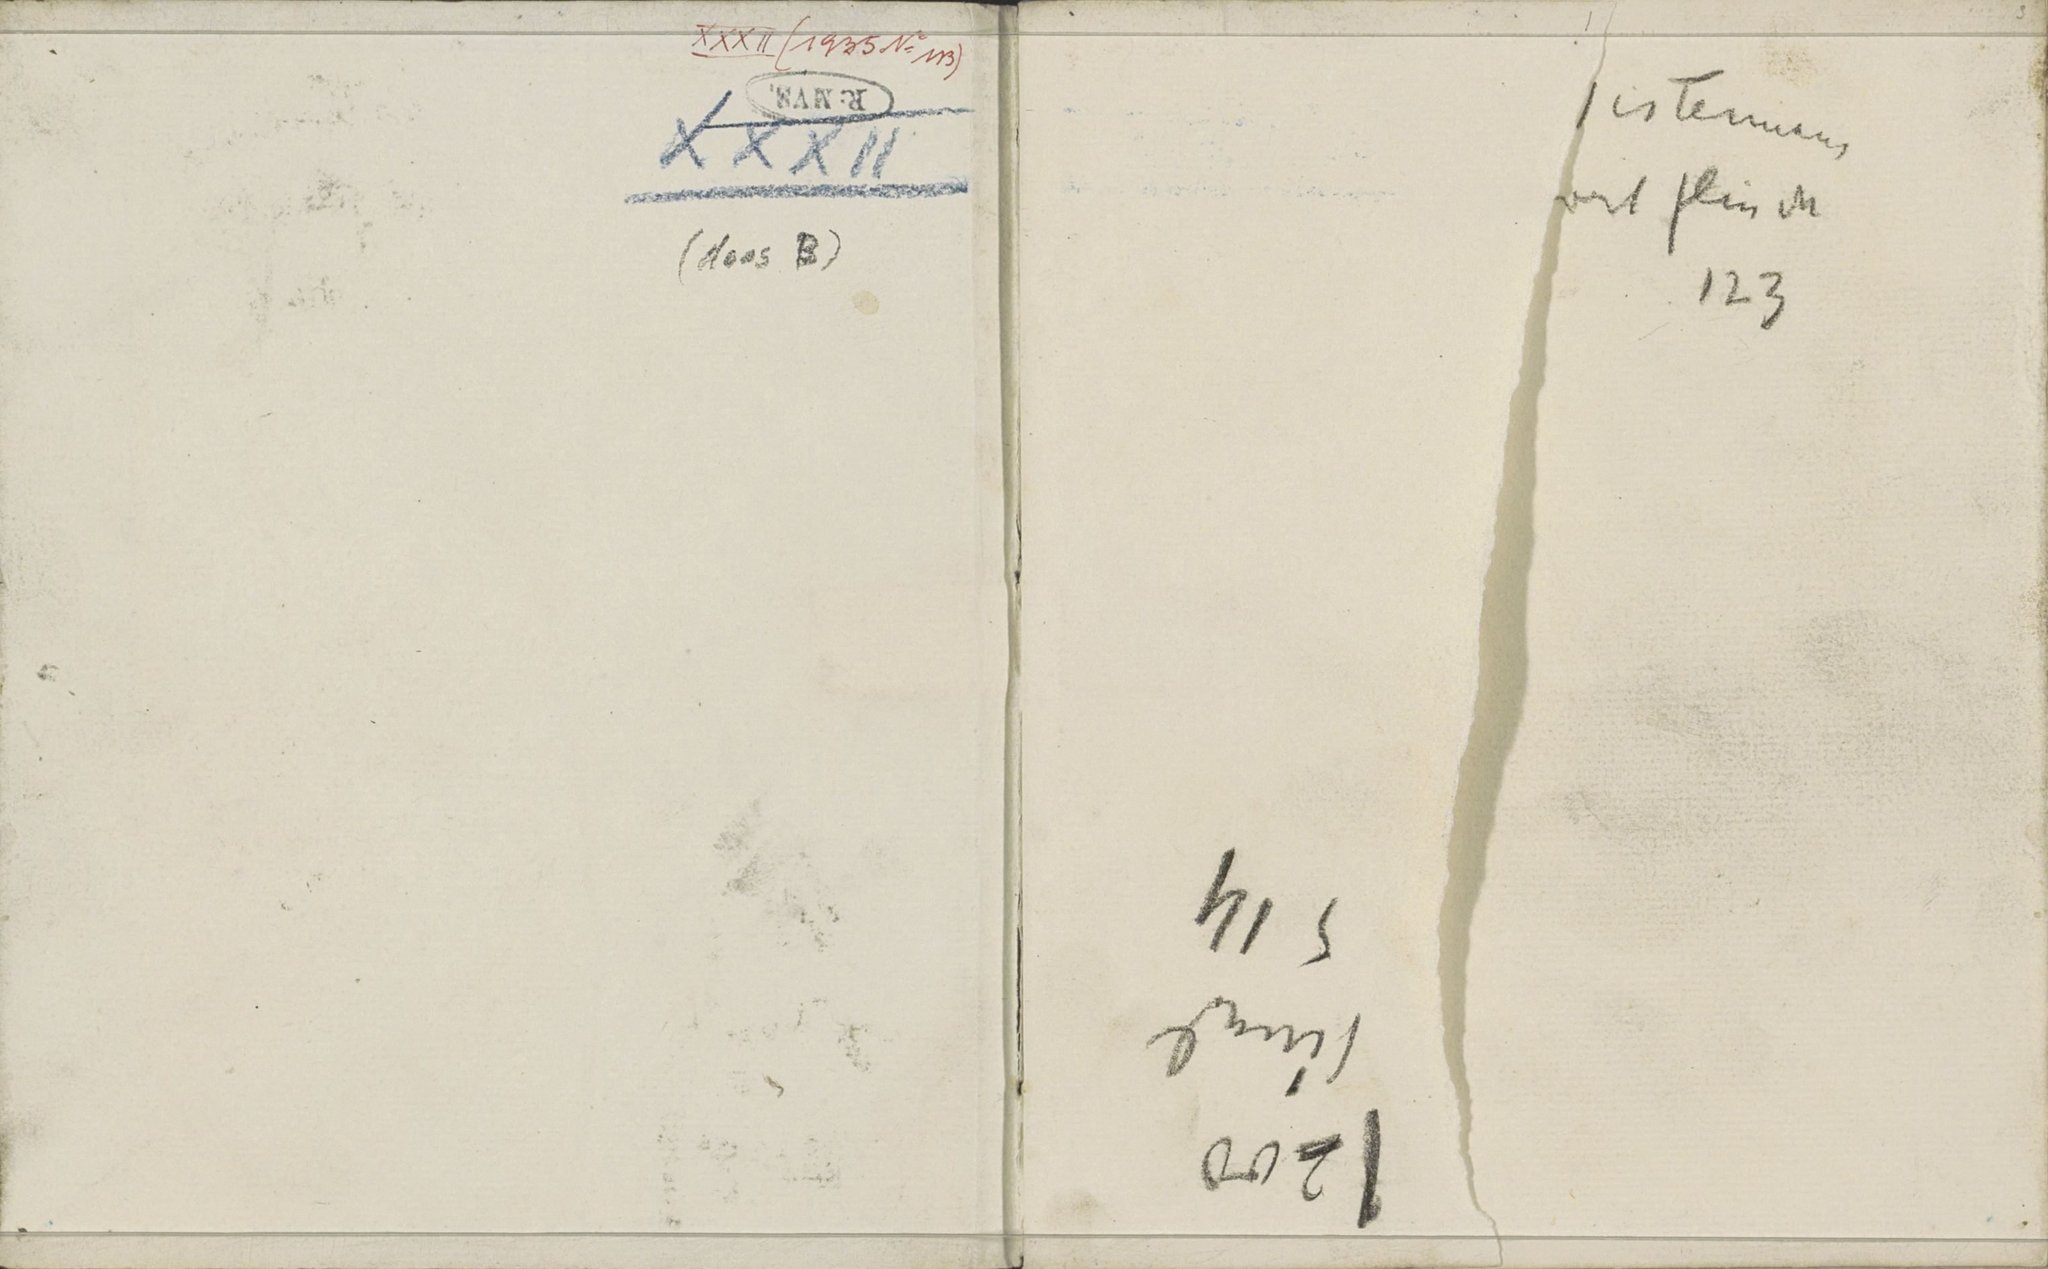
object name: sketchbook leaf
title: Annotatie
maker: isaac israels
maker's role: draughtsman, painter, print maker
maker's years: 1865-1934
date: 1886-1903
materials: chalk, paper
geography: amsterdam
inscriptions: annotation: ‘1200 / Singel[?] / 514’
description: Pagina 1 uit schetsboek XXXII met 92 pagina's.